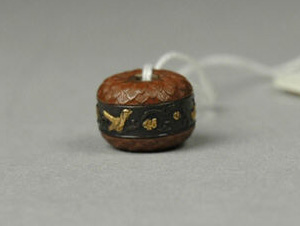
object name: ojime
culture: japanese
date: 1801-1900